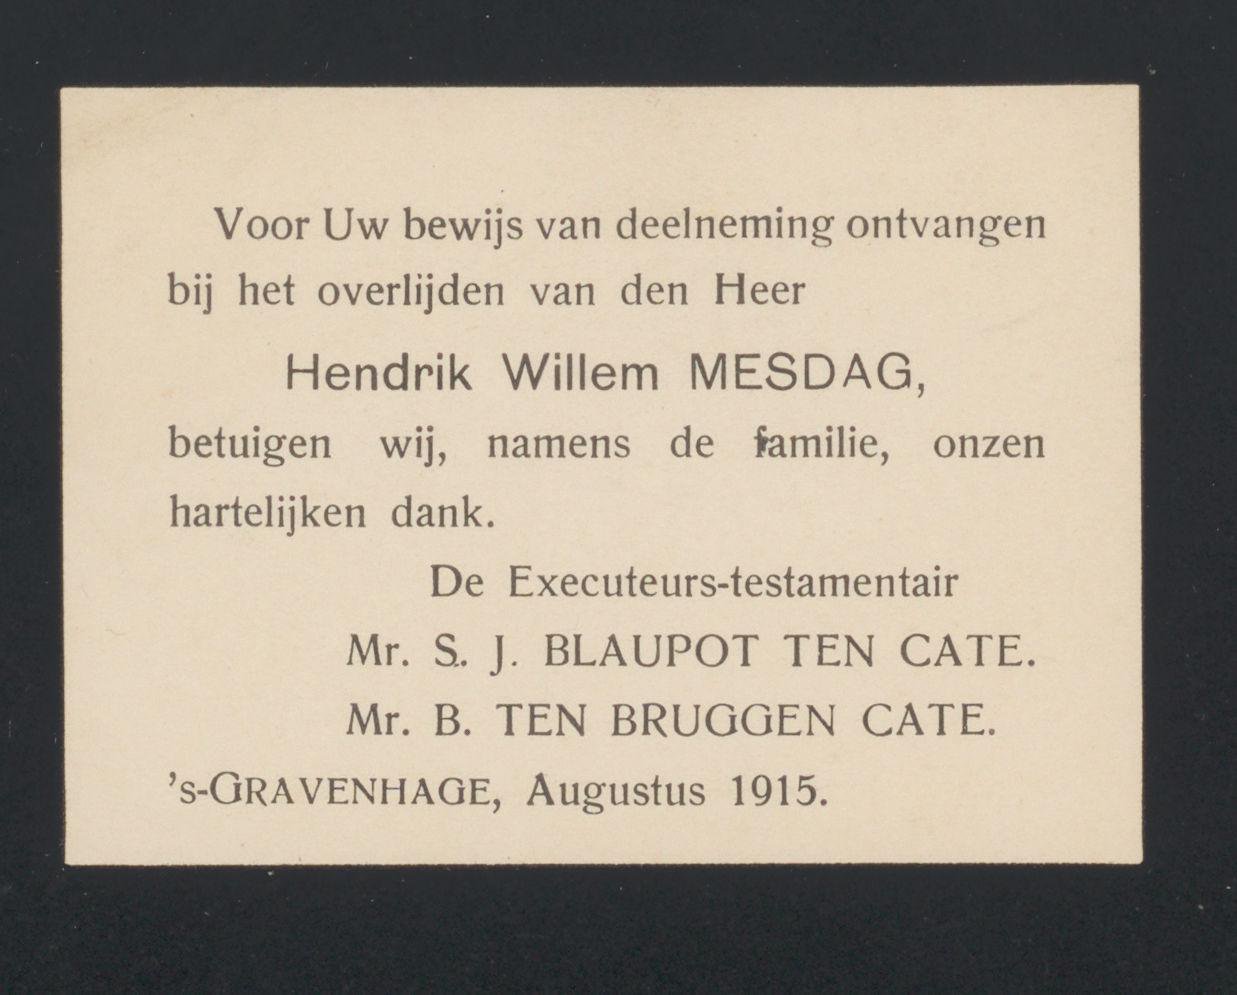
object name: bedankkaart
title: Bedankkaart aan Philip Zilcken en Henriette Wilhelmina van Baak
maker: s.j. blaupot ten cate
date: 1915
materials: cardboard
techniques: printing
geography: the hague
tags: painter, print maker, draughtsman, hendrik willem mesdag, henriette wilhelmina van baak, philip zilcken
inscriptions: collector's mark: ‘RPK’